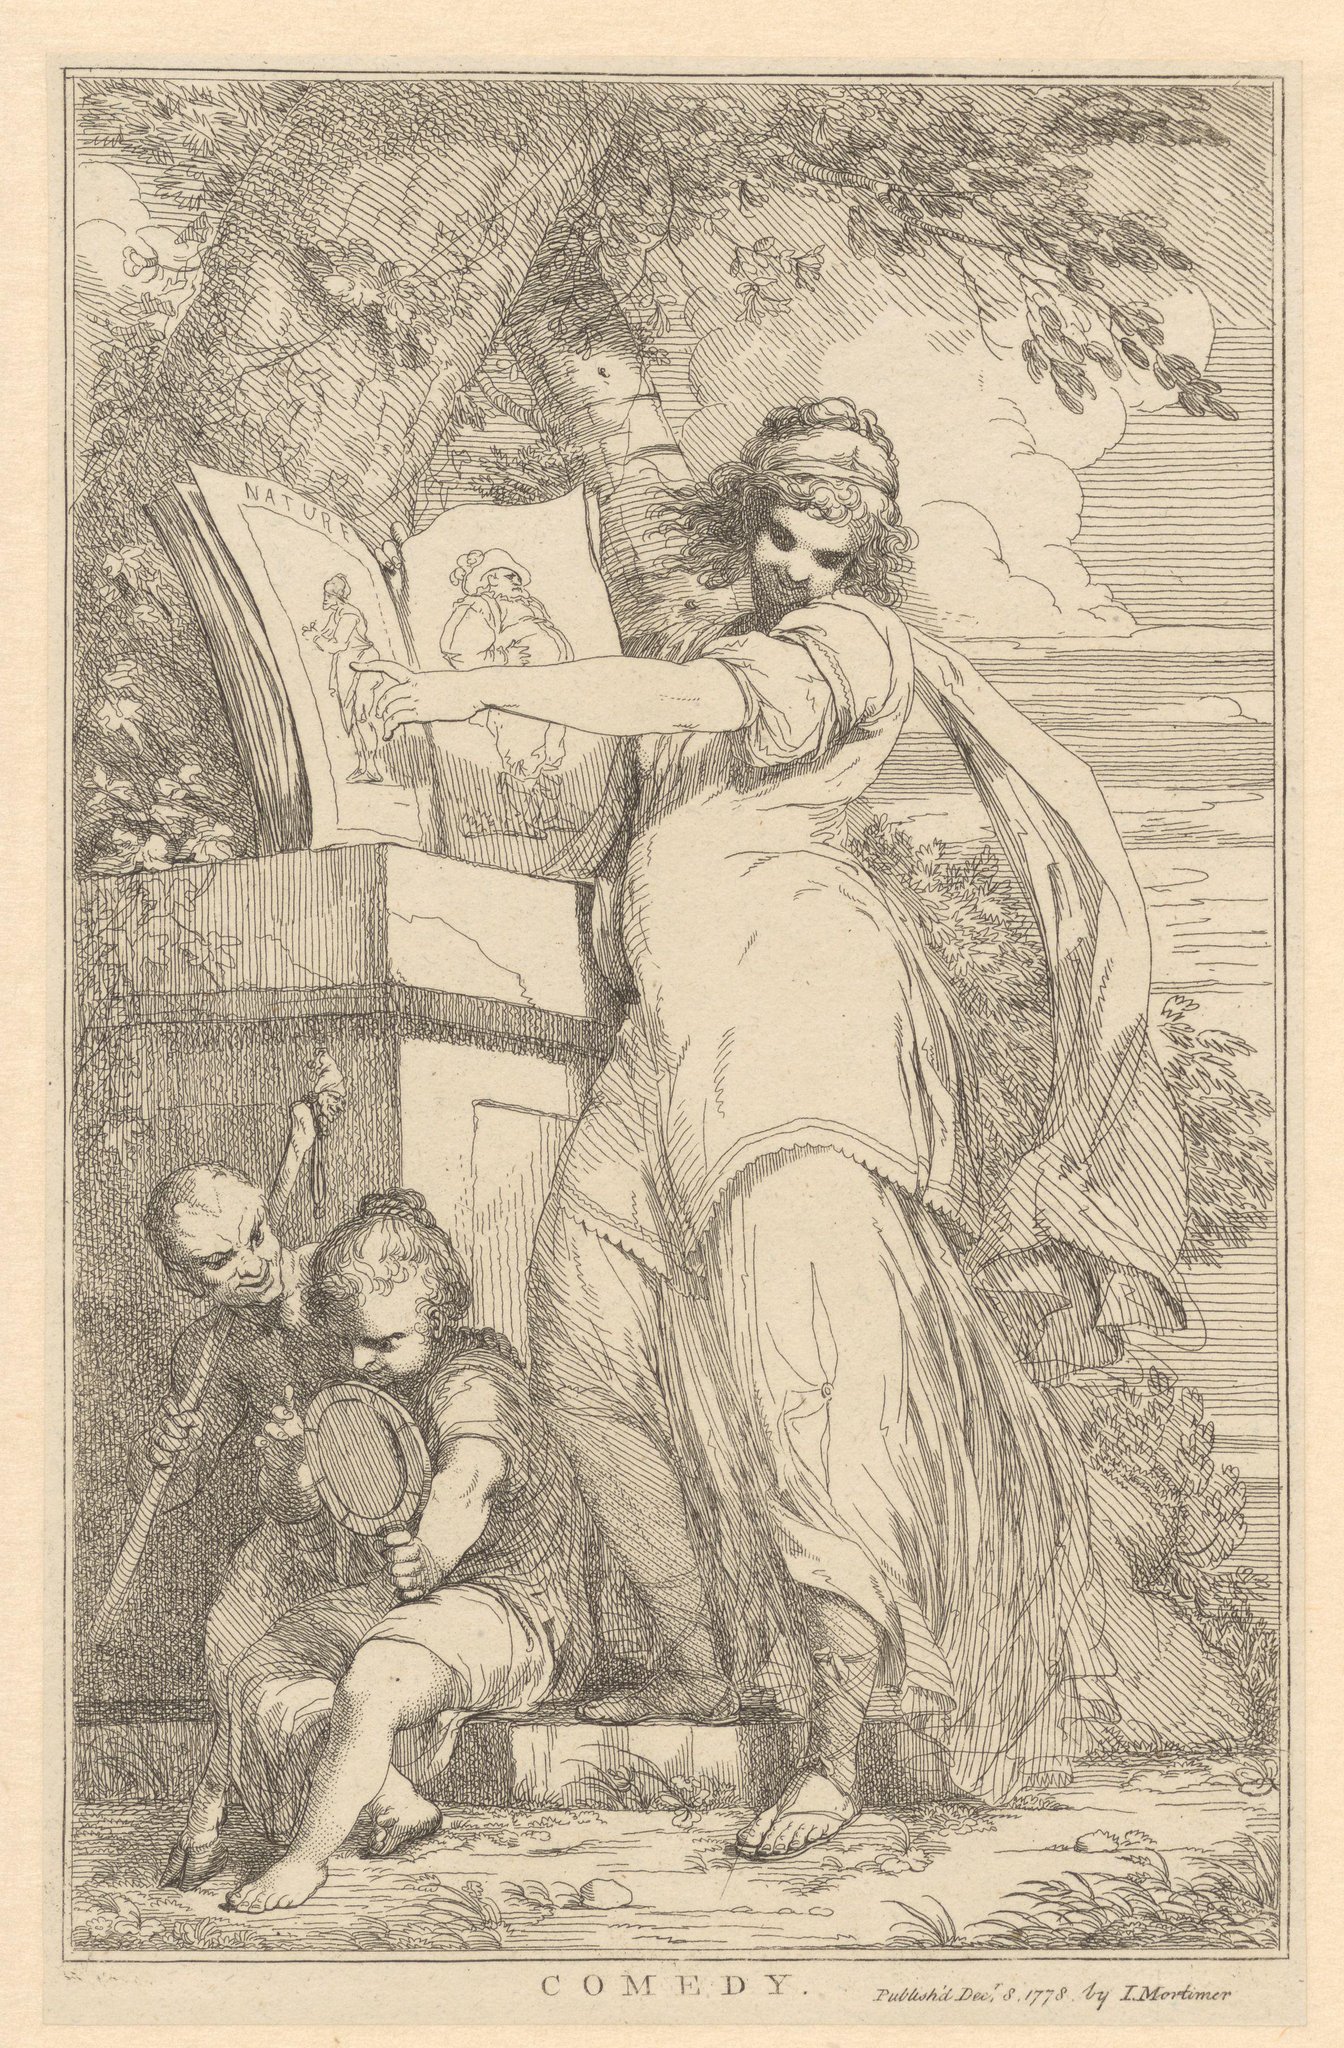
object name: print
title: Vijftien etsen opgedragen aan Joshua Reynolds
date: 1712-1778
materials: paper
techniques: etching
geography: london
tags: looking in the mirror; contemplation of own beauty, book - mm - book open, satyr(s) (in general), index finger forwards, pointing, indicating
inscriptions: collector's mark: Lugt 2760, collector's mark: Lugt 2228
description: De vrouw lacht richting een kind met spiegel en een sater, die op de rand van een altaar zitten.